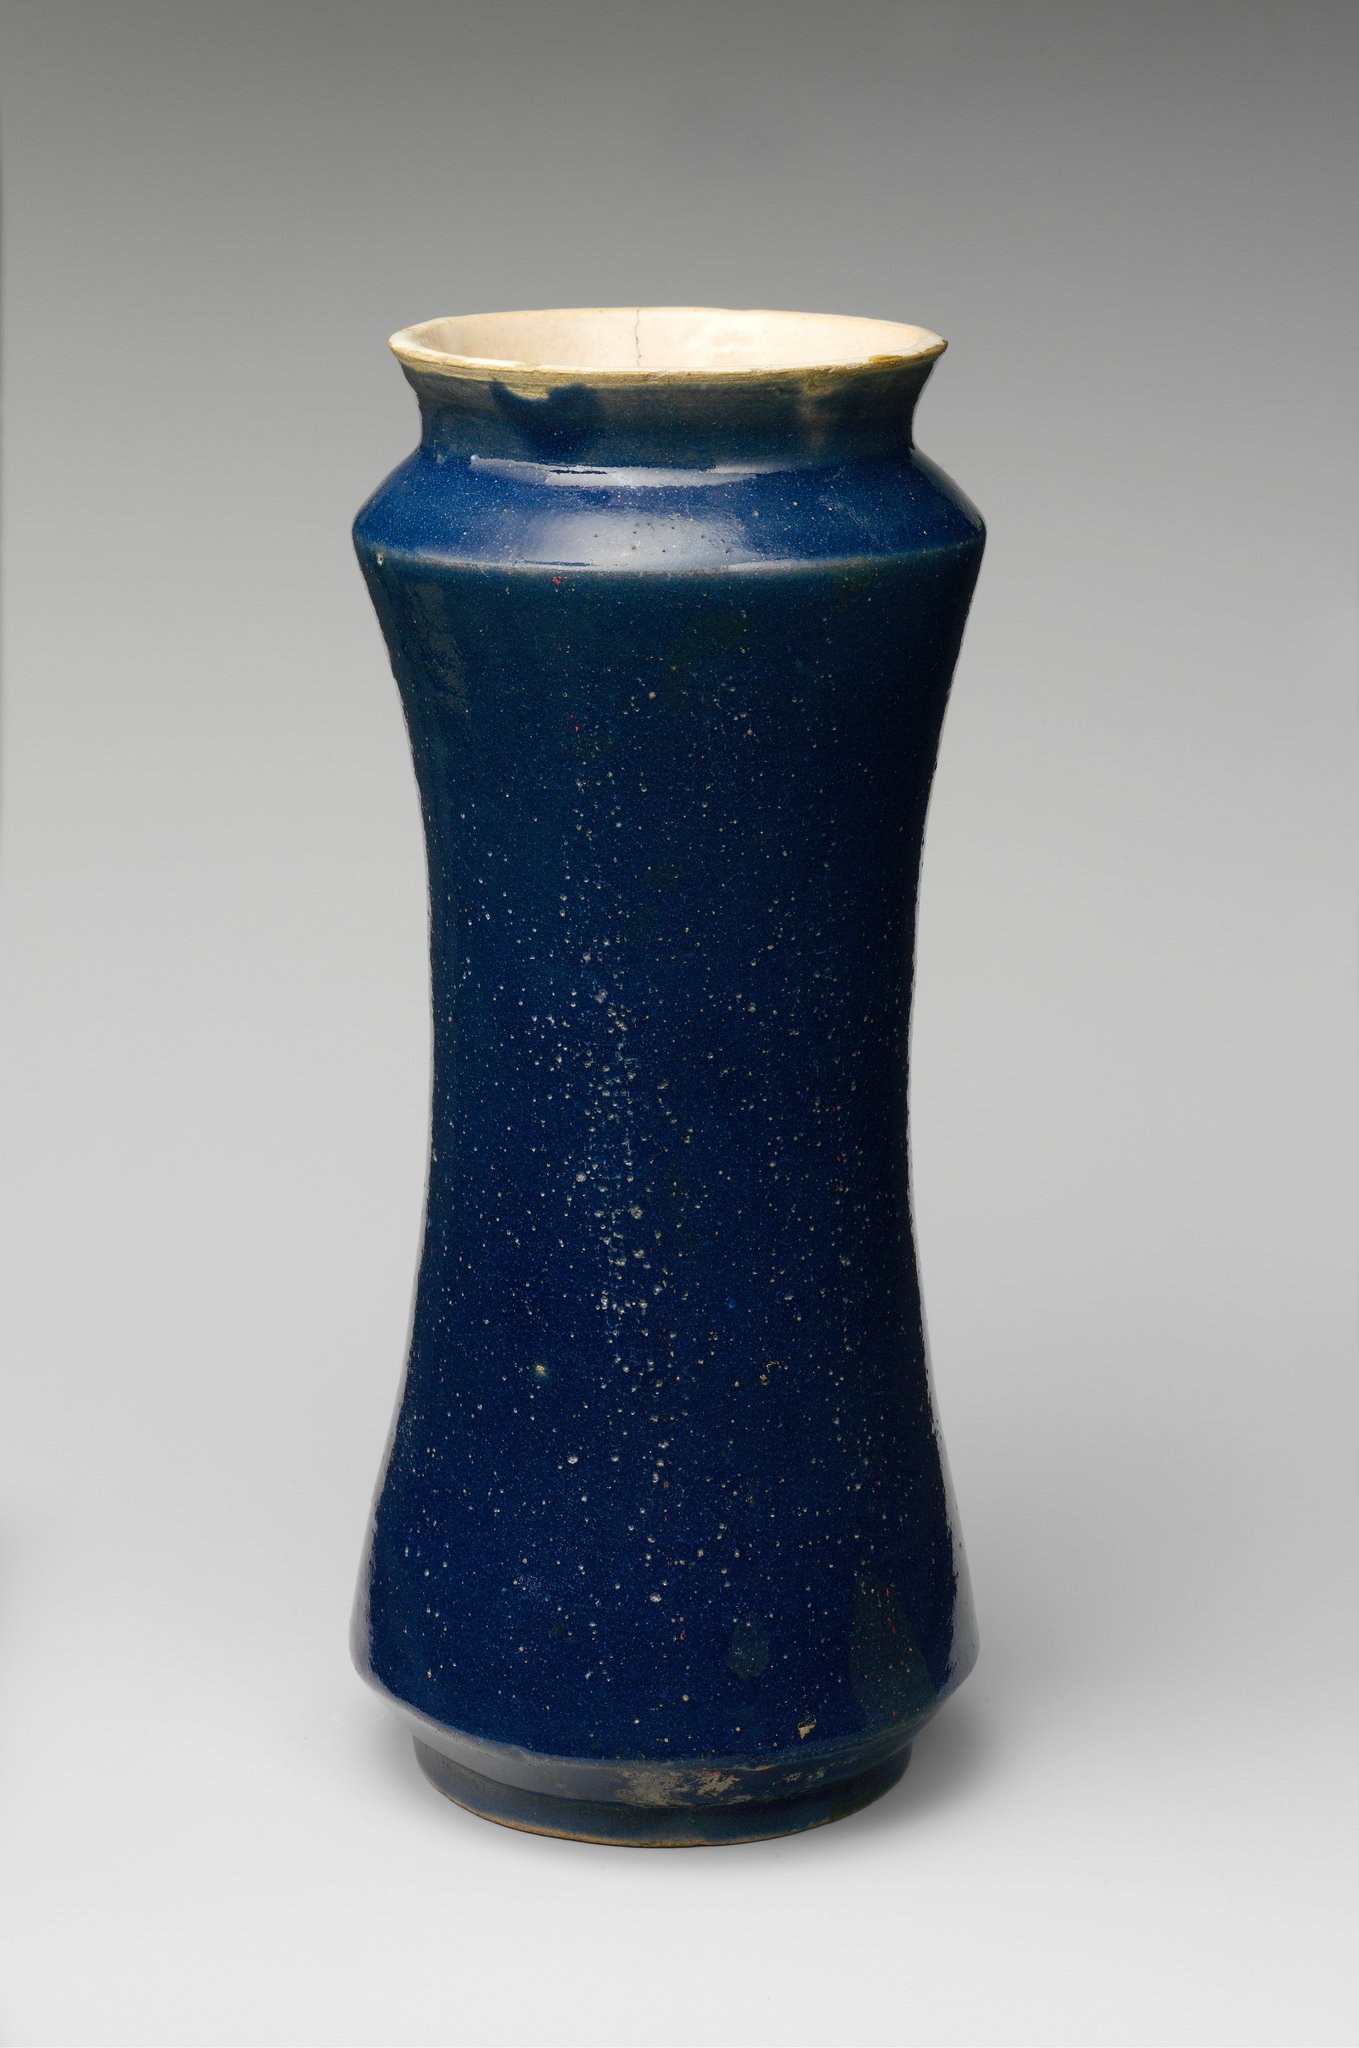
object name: apothecary jar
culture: mexican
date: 1840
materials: earthenware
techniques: glazing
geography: mexico